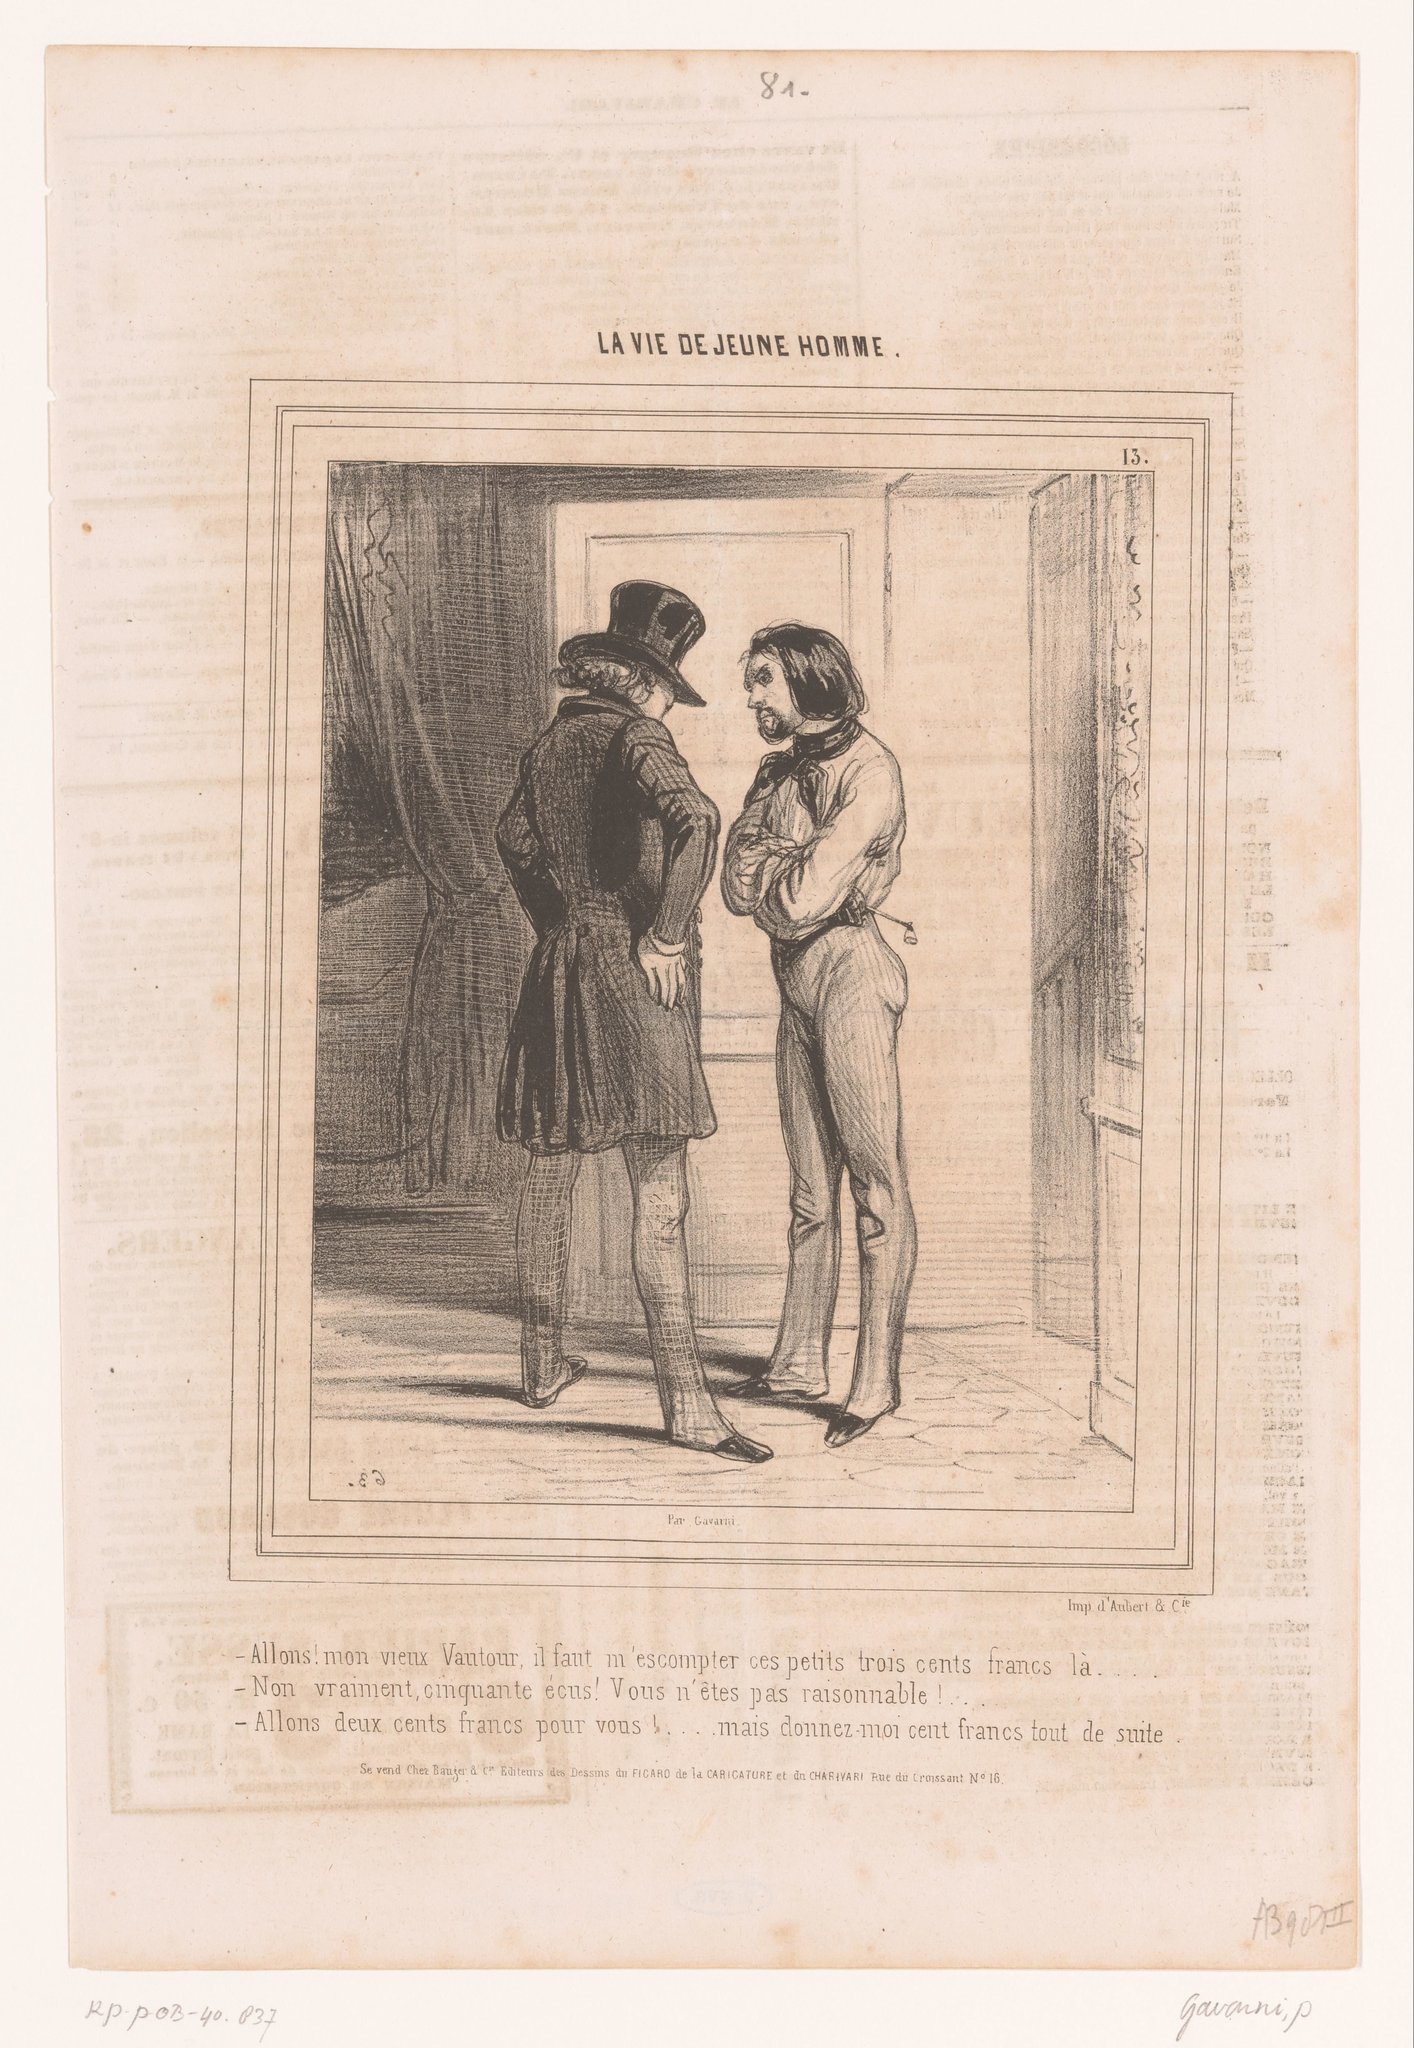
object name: cartoon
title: Jongeman onderhandelt met een woekeraar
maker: paul gavarni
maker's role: draughtsman, print maker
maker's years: 1804-1866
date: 1841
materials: paper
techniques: lithograph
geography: paris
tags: standing figure, money-lender, usurer, student life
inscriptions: collector's mark: Lugt 2228a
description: Prent gebruikt voor: Le Charivari, 28 april 1841.